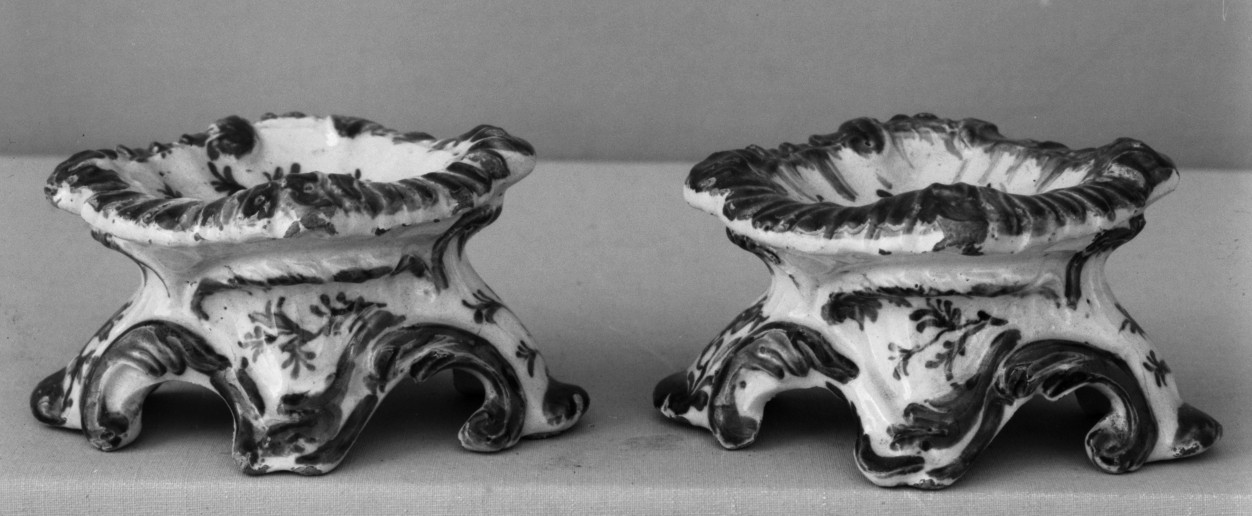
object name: saltcellar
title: Pair of saltcellars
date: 1751-1775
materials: earthenware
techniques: glazing